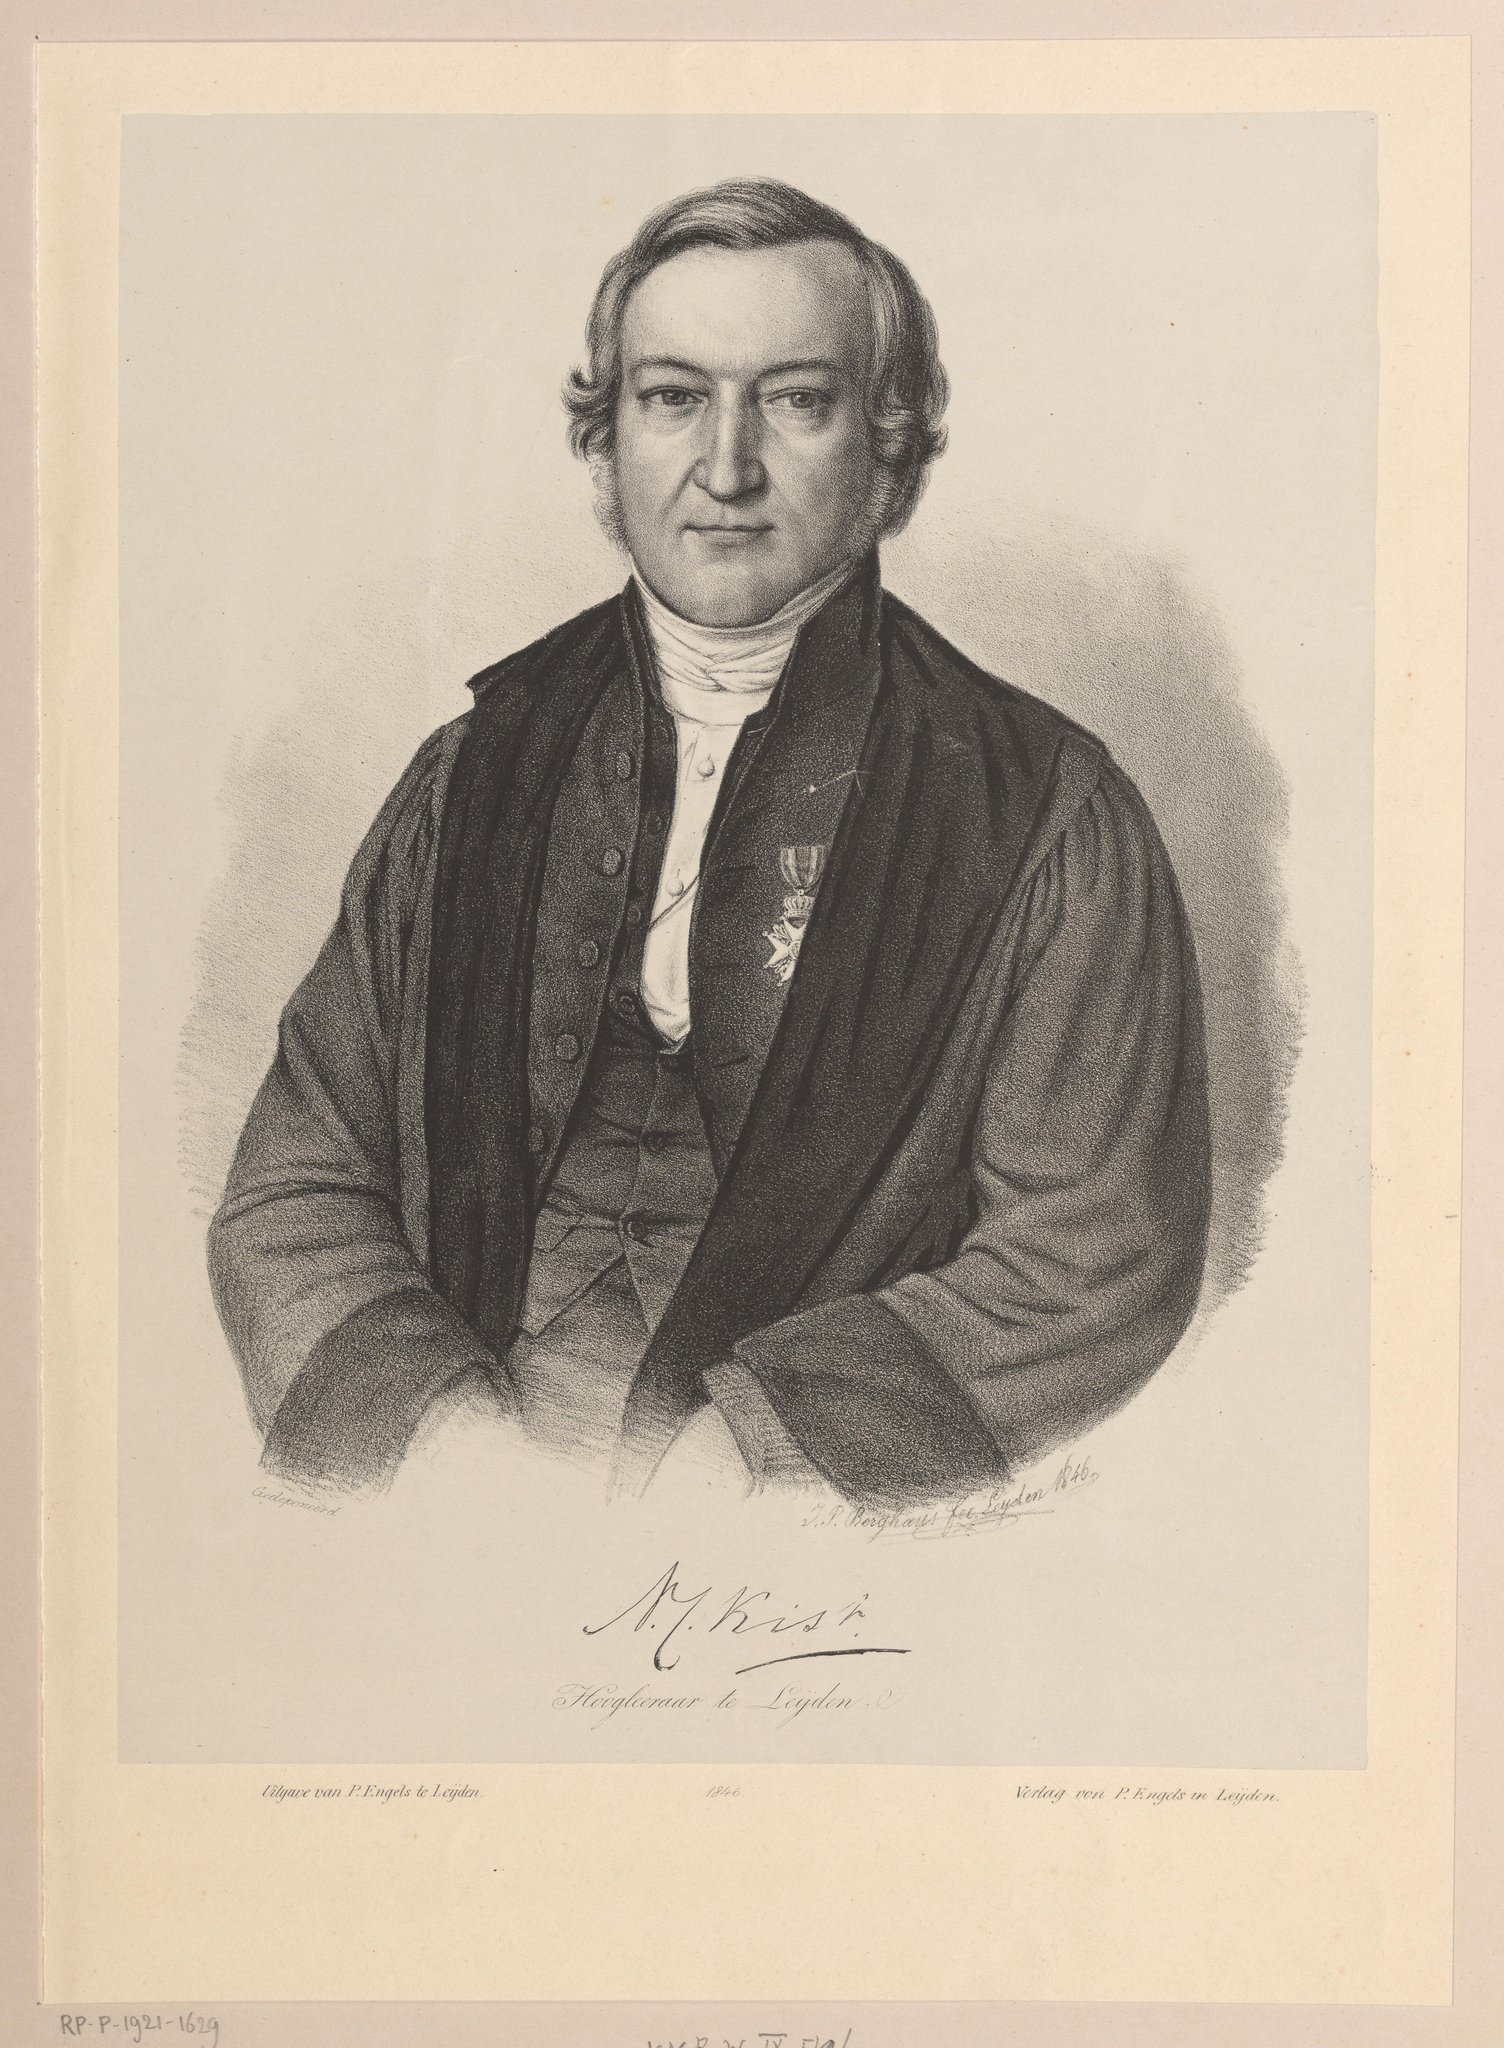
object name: print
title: Portret van Nicolaas Christiaan Kist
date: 1846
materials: paper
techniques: lithograph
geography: leiden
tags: leiden, historical persons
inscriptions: collector's mark: Lugt 2233